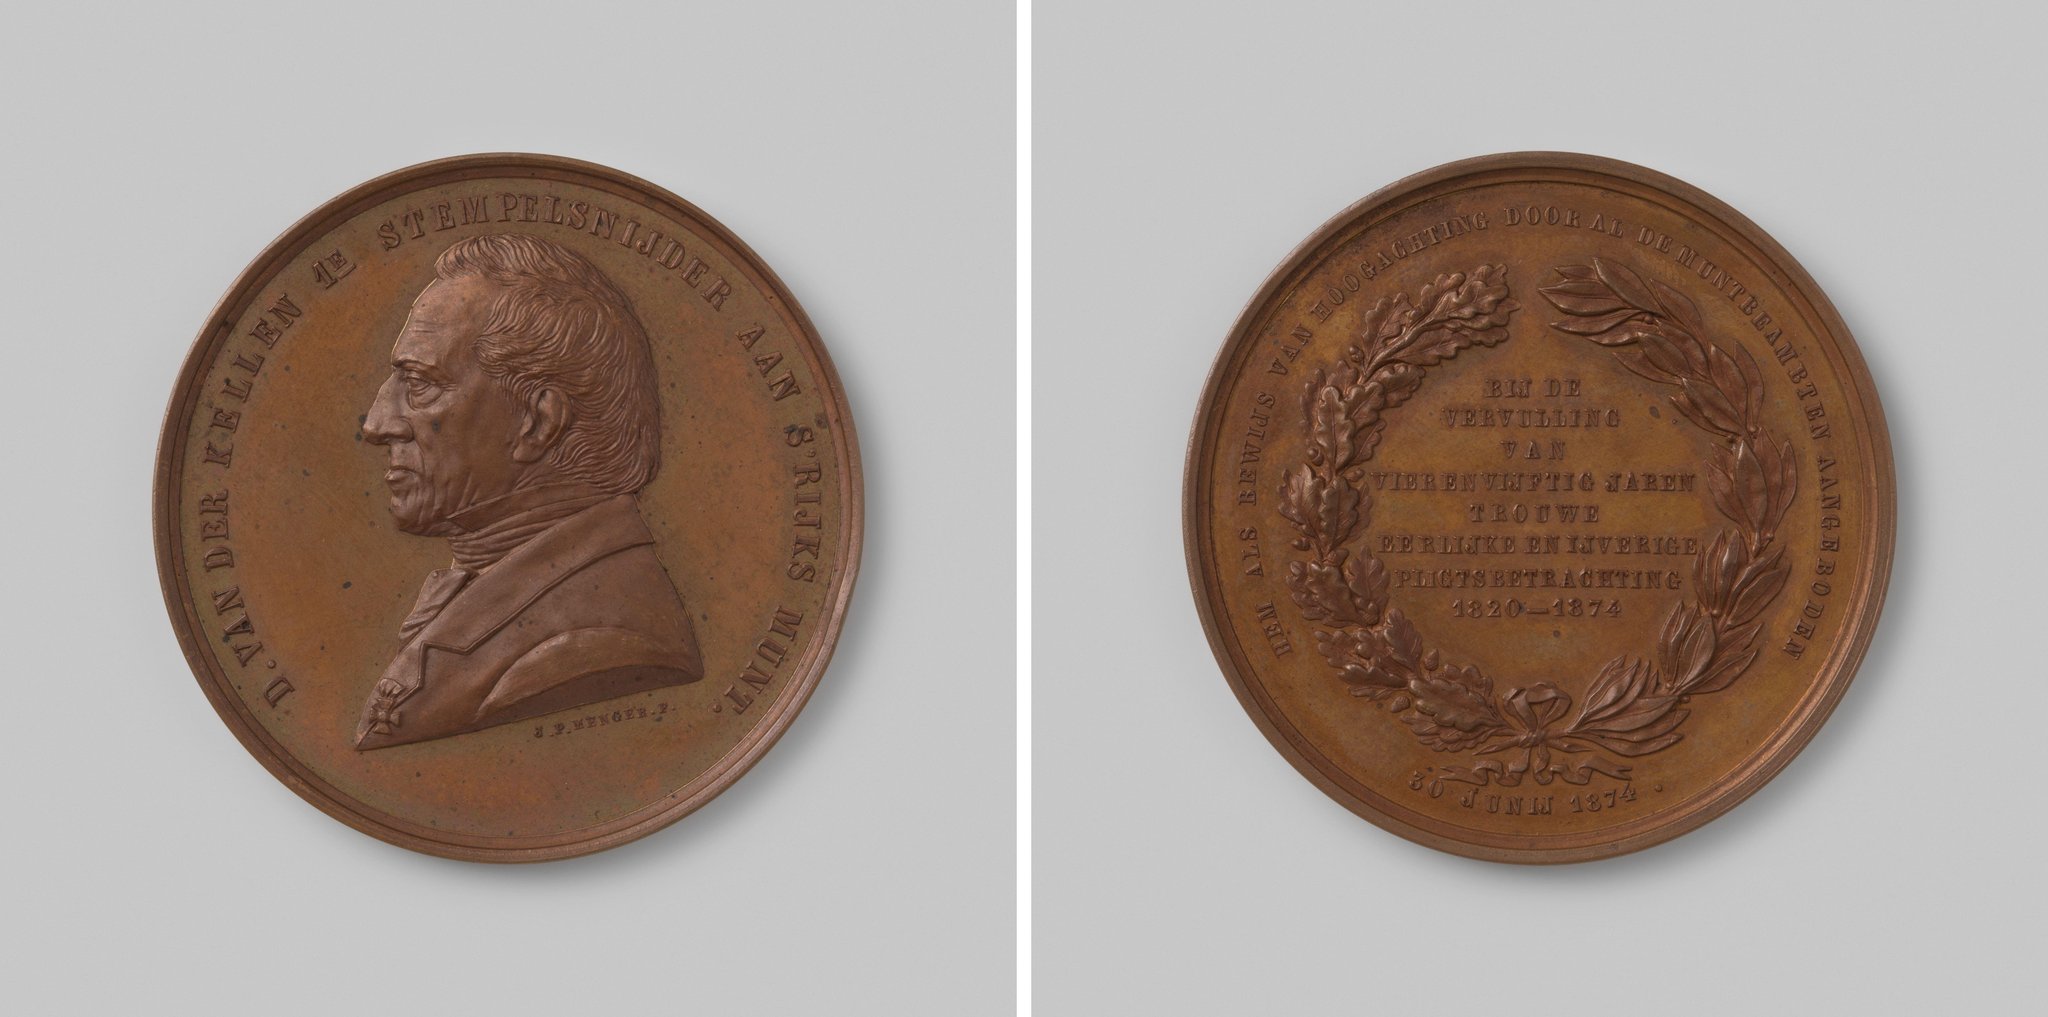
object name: honorary medal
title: David van der Kellen jr., gepensioneerd na vierenvijftig jaar aan de Rijksmunt te Utrecht werkzaam te zijn geweest, penning aangeboden door zijn collega's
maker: johan philip menger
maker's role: medailleur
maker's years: 1818-1895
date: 1874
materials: bronze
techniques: striking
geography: utrecht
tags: amsterdam, print maker, draughtsman, david van der kellen (1804-1879), utrecht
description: Bronzen penning. Voorzijde: borststuk man binnen omschrift. Keerzijde: opschrift binnen tot krans samengebonden eike- en aluwertak en omschrift; randschrift: naam H. A. van den Wall Bake, muntmeester te Amsterdam